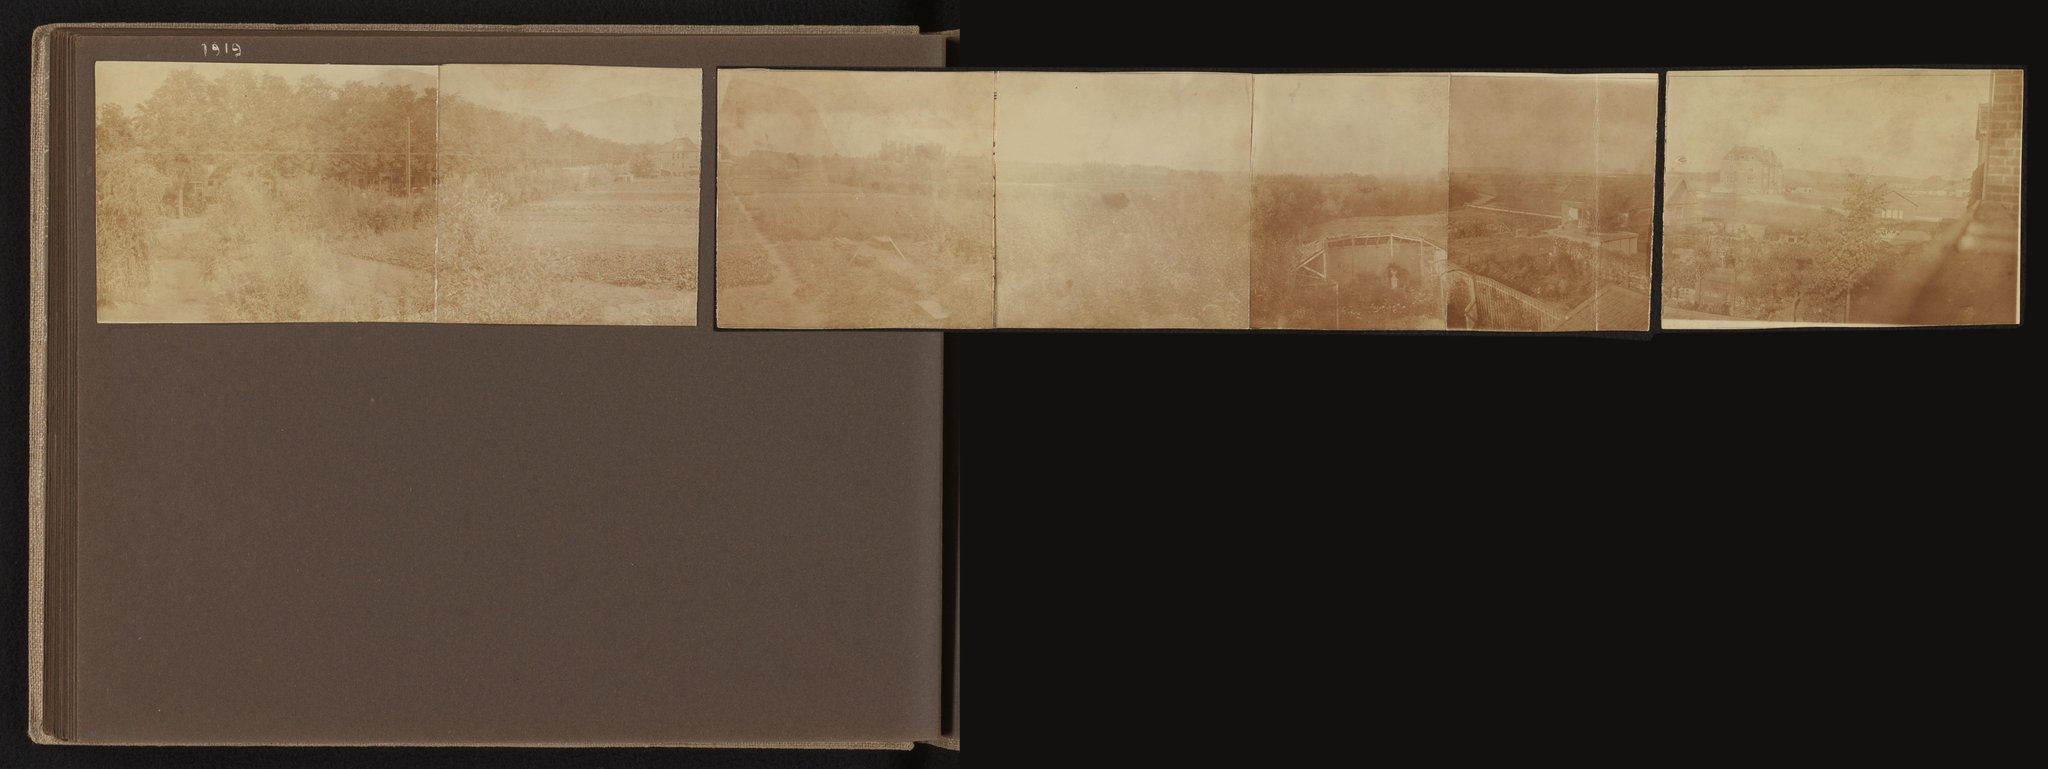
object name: album leaf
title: Panorama gezicht op een weiland, tuinen en huizen vanaf een balkon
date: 1919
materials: paper, cardboard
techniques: collodion silver print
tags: panorama, cyclorama, garden, meadow, pasture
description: Deze foto's maken deel uit van een album. De zeven foto's zijn op papier met advertenties geplakt en vormen samen één beeld.